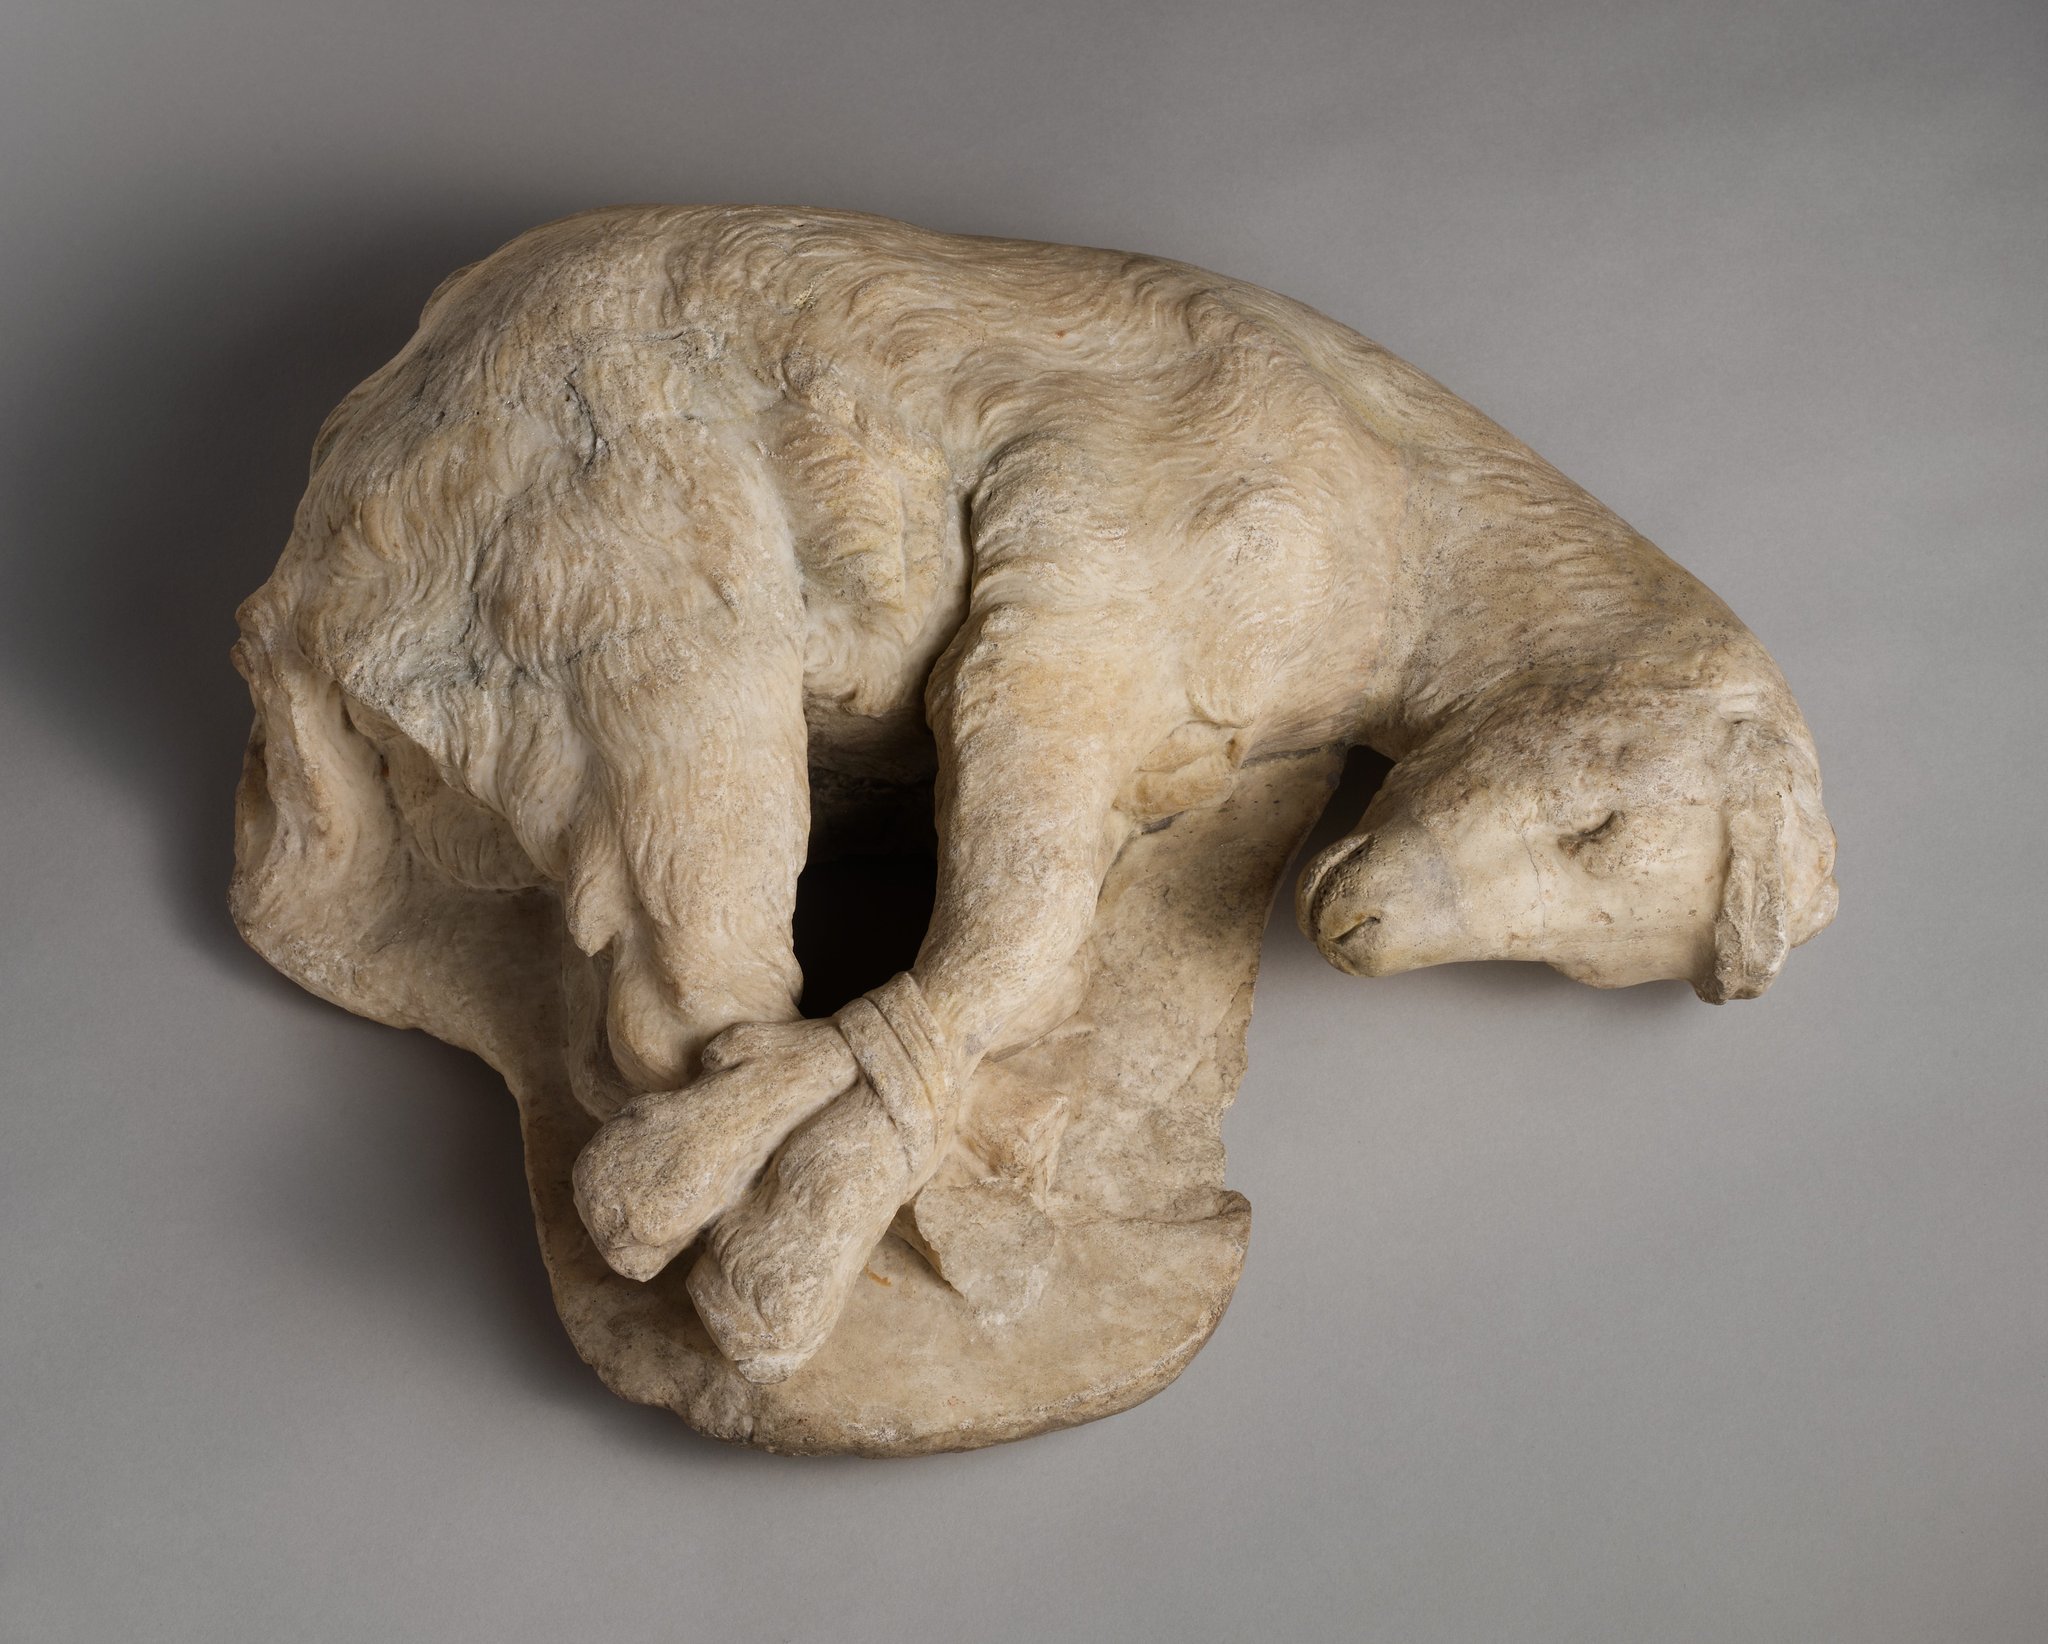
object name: statue of a bound goat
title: Marble statue of a bound goat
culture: roman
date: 1-200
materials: marble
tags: goats